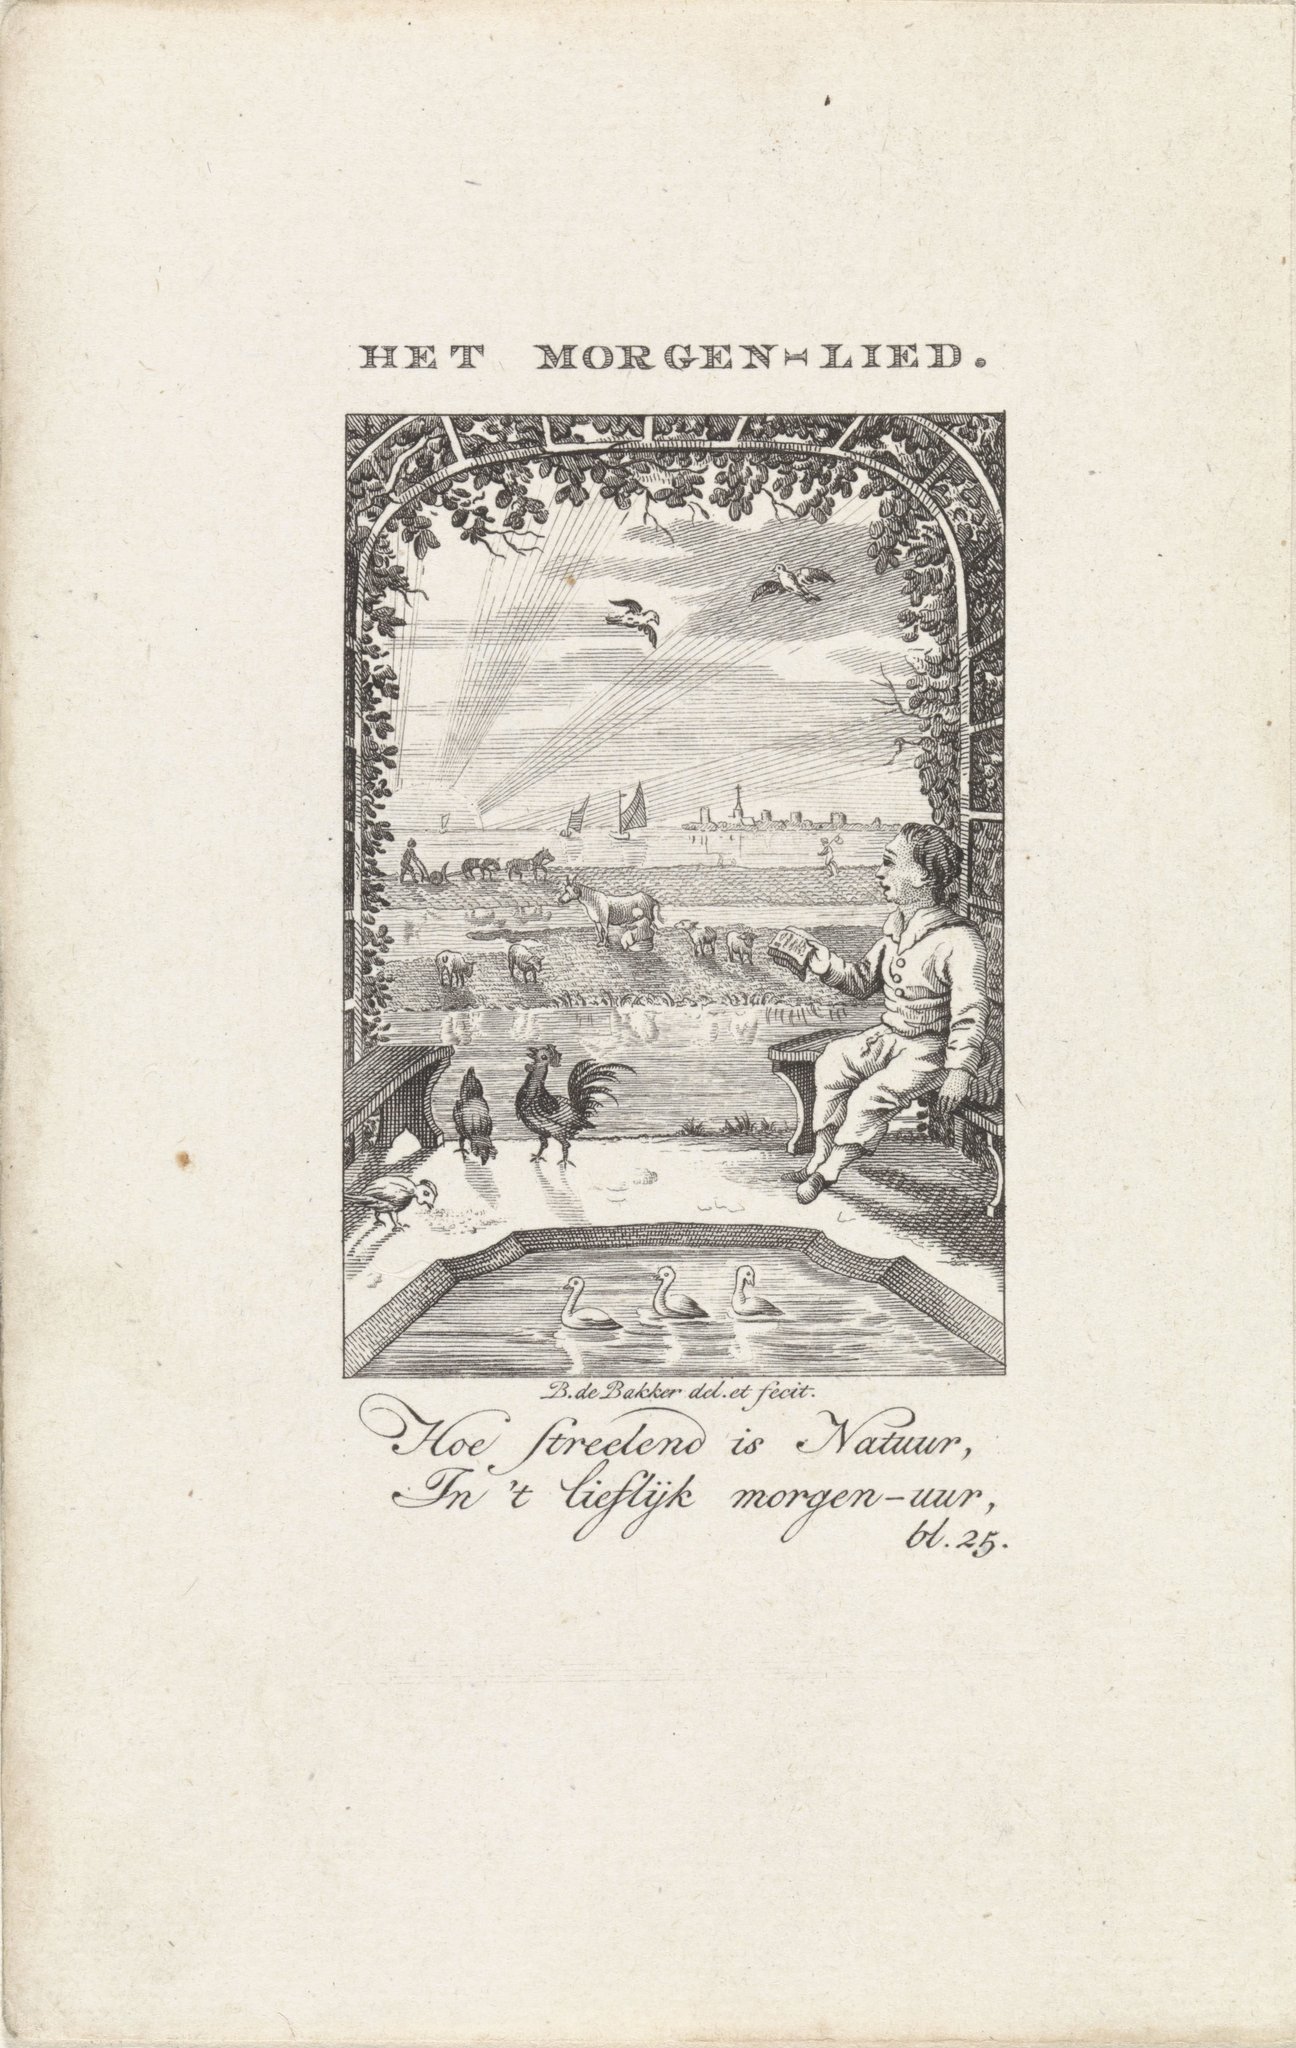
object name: print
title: Kind zit in prieel en zingt bij zonsopkomst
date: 1789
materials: paper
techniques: engraving, etching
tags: child, children singing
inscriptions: collector's mark: Lugt 2760, collector's mark: Lugt 2228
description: Kind zit in prieel en zingt bij zonsopkomst. Het opschrift is een citaat uit Kinderpligt en zinnebeelden (blad 25).